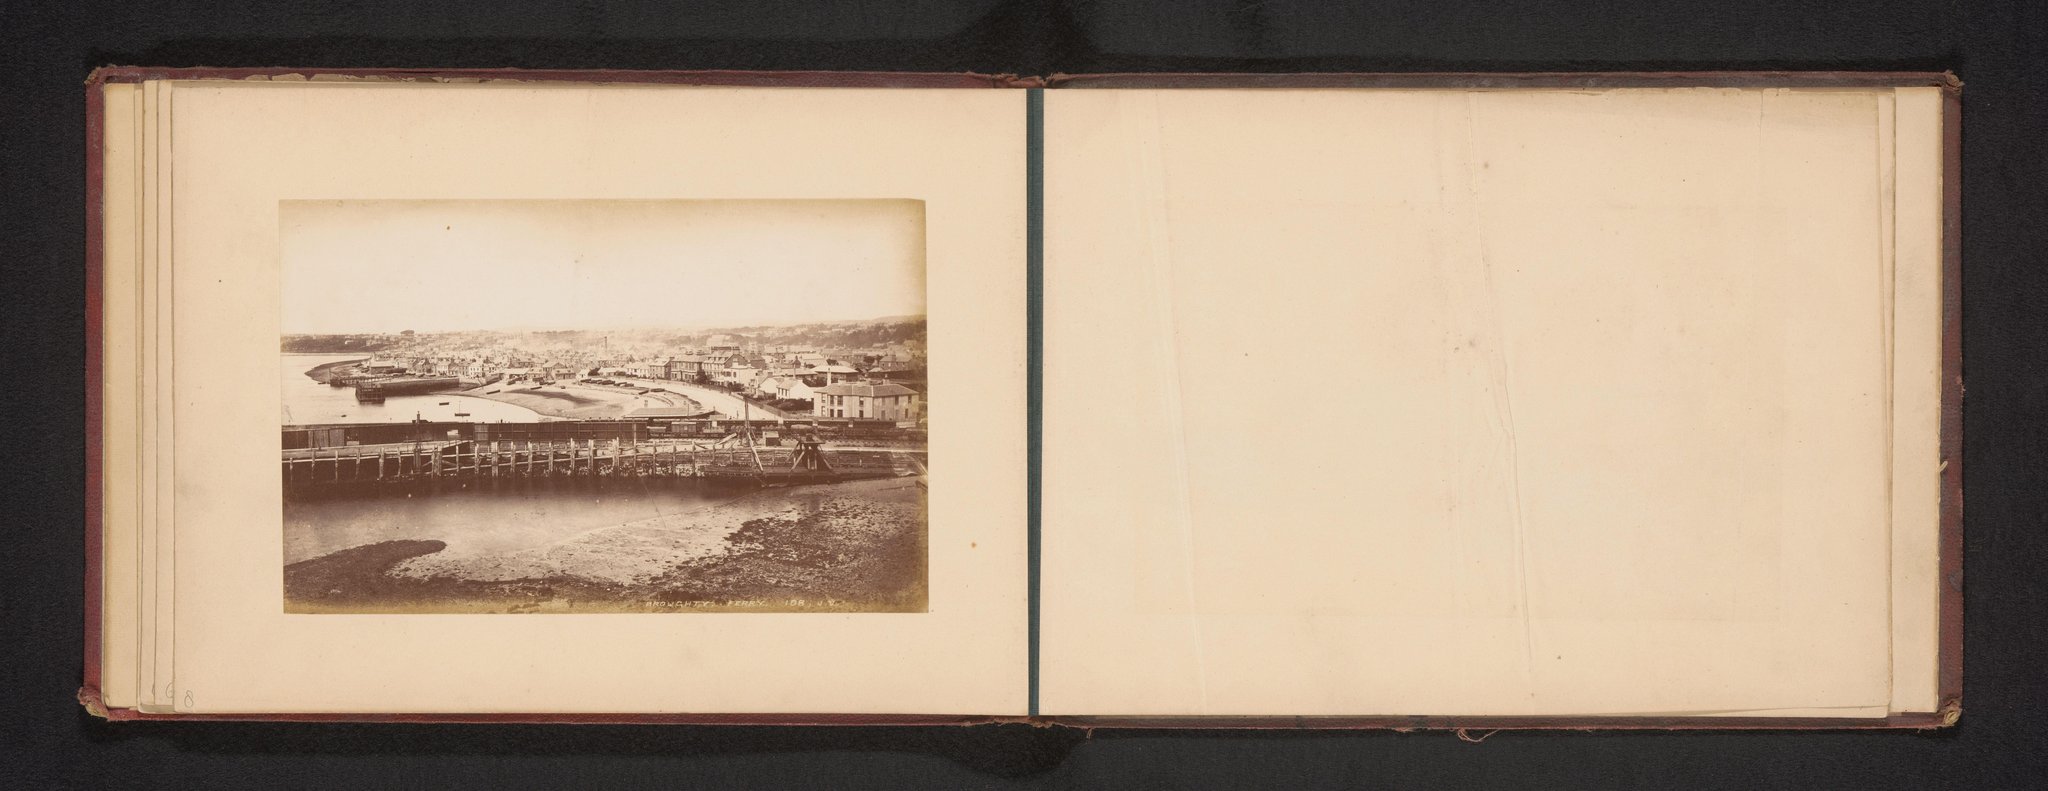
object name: page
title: Gezicht op Broughty Ferry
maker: james valentine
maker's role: fotograaf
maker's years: 1815-1880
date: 1872-1877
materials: photographic support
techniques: albumen print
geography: broughty ferry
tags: city-view, and landscape with man-made constructions, landscapes with waters, waterscapes, seascapes (in the temperate zone)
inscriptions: number: ‘108 j.v.’